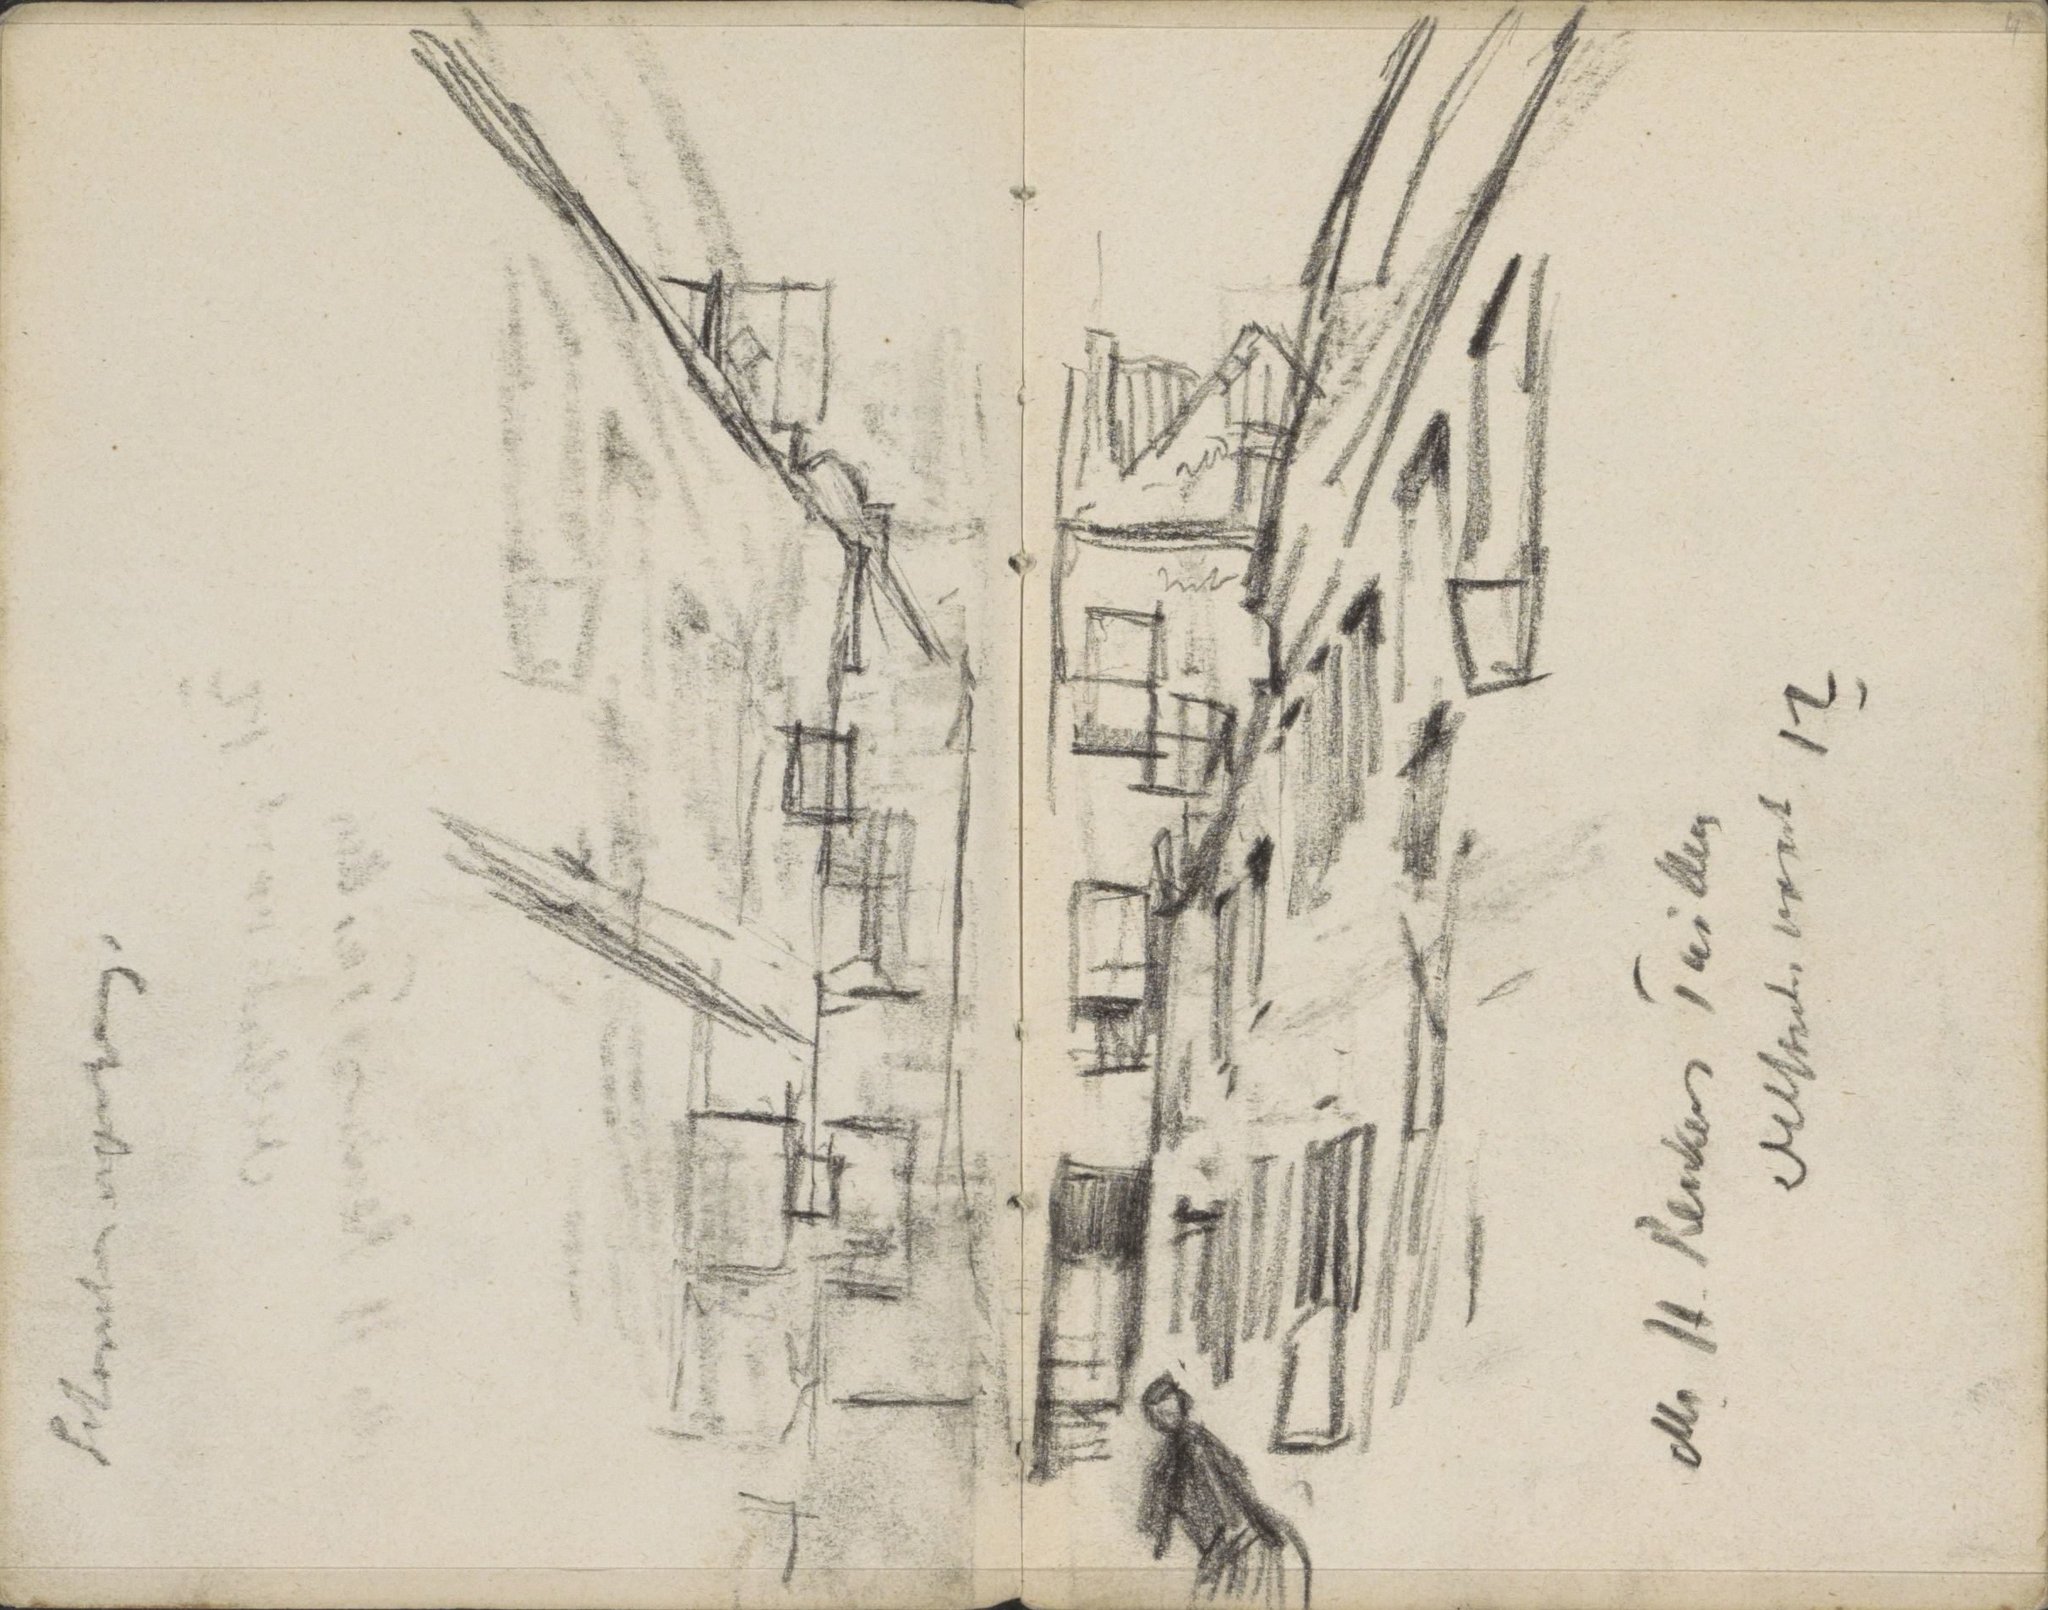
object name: sketchbook leaf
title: Gezicht op een straat of steeg in Rotterdam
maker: george hendrik breitner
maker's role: draughtsman, painter, print maker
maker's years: 1857-1923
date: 1907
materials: chalk, paper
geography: rotterdam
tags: urban housing, lane, alley, street, rotterdam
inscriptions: annotation: ‘dhr. H. Renkes[?] Tuill[...] / Delfsche vaart 12’, annotation: ‘Sch[...]steeg[?]’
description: Gezicht op een straat of steeg in Rotterdam, mogelijk in de buurt van de Delftsevaart. Pagina 3 en pagina 4 uit een schetsboek met 46 bladen vervaardigd in Amsterdam, Rotterdam en Haarlem.